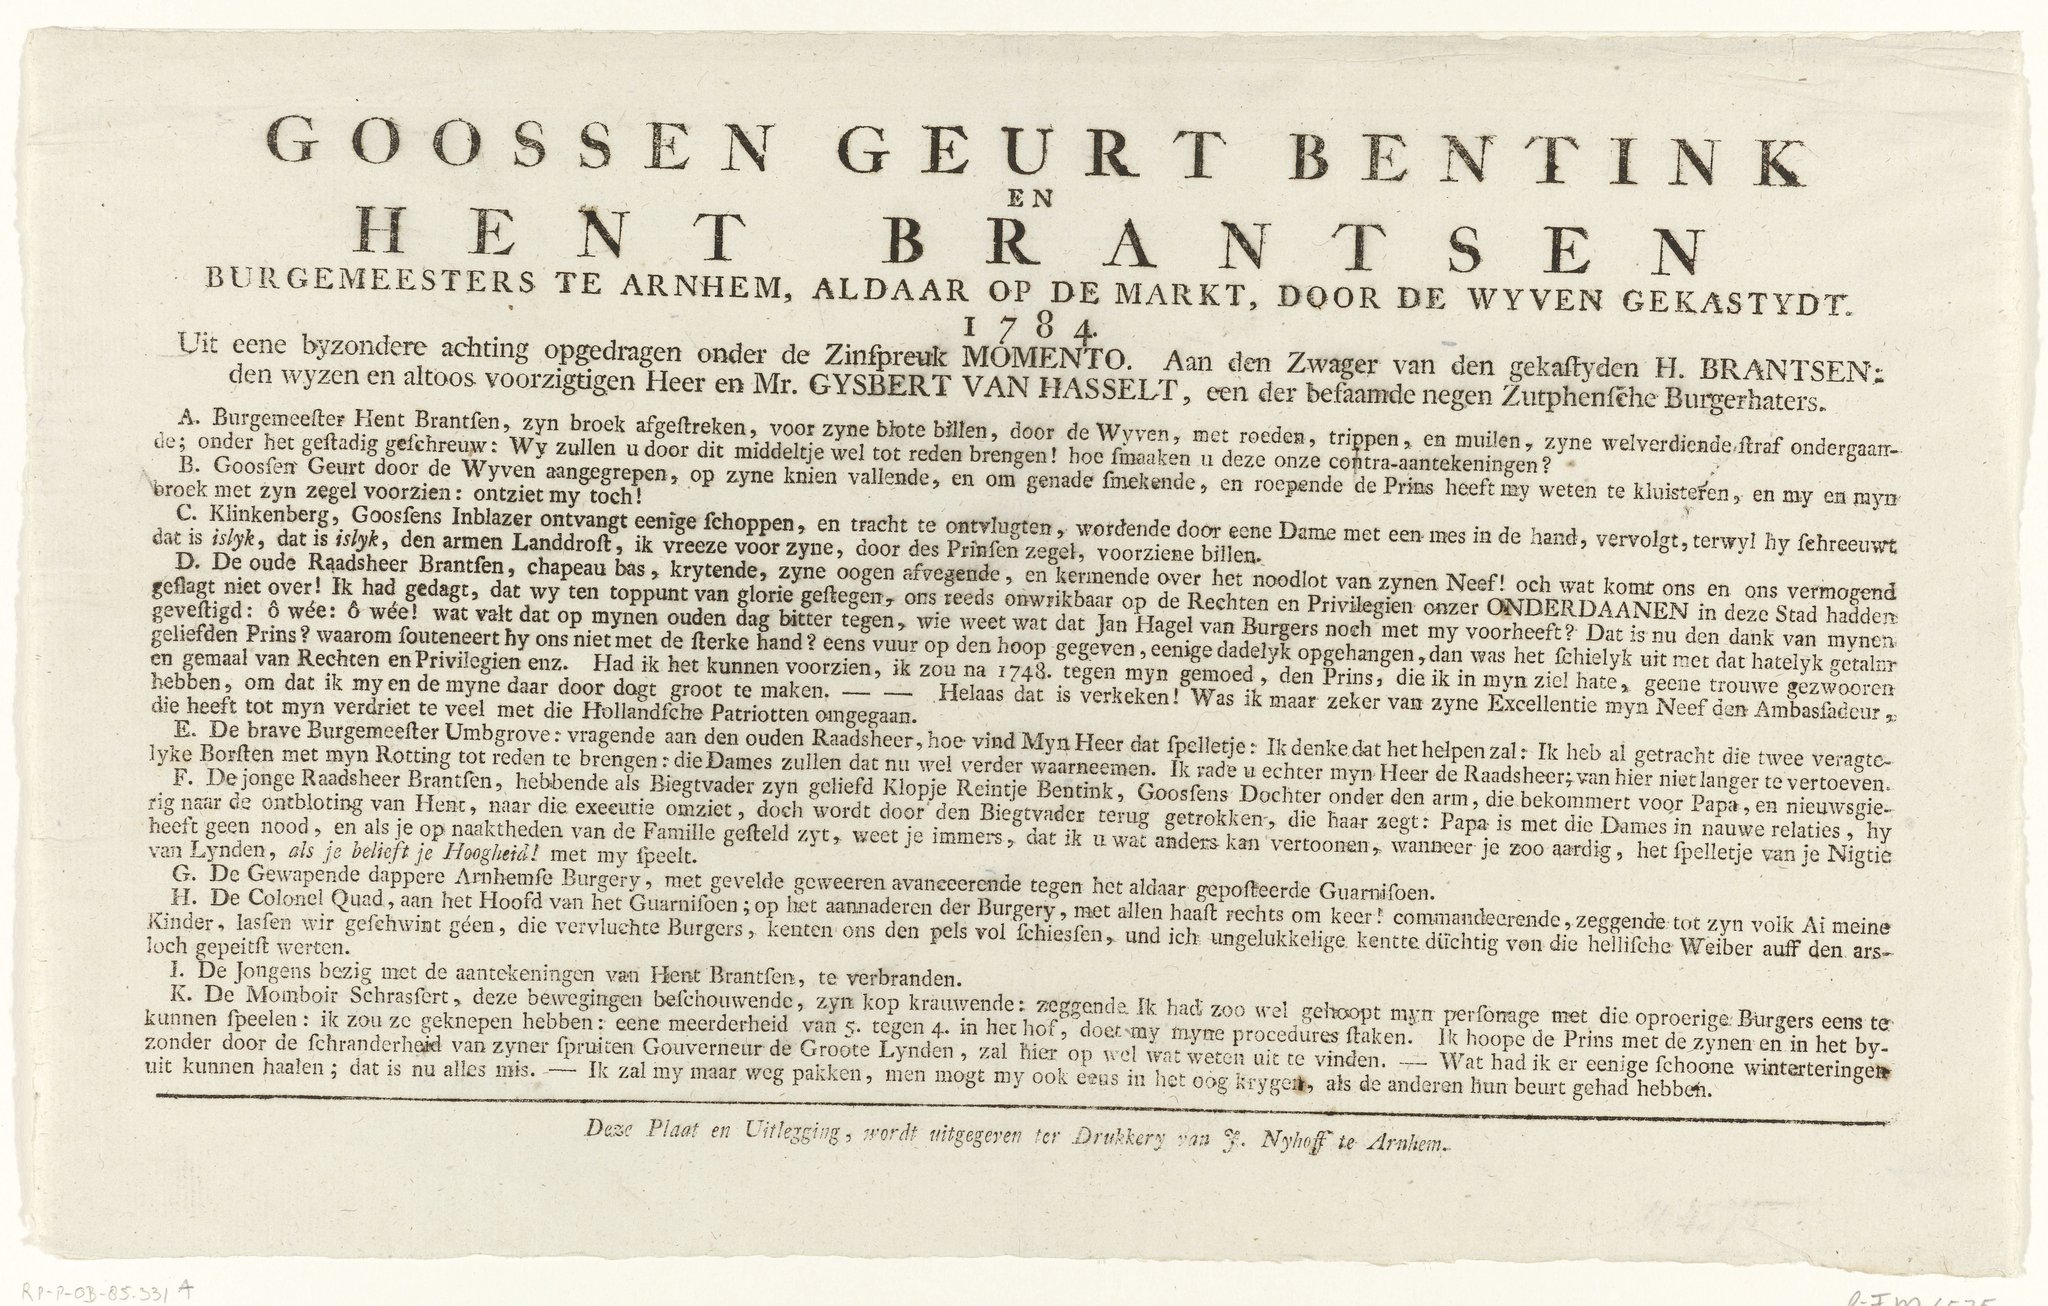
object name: cartoon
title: Goossen Geurt Bentink en Hent Brantsen Burgemeesters te Arnhem, aldaar op de markt, door de wyven gekastypt. 1784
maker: jacob nijhoff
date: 1784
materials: paper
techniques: letterpress printing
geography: arnhem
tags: arnhem, patriots (1780-1795)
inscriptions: collector's mark: Lugt 2228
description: Tekstblad met een verklaring van de letters A-K in de spotprent waarin de Arnhemse burgemeesters Gosen Geurt Bentinck en Hent Brantsen op de markt voor het stadhuis door vrouwen met takkenroedes worden gekastijd, 1784.